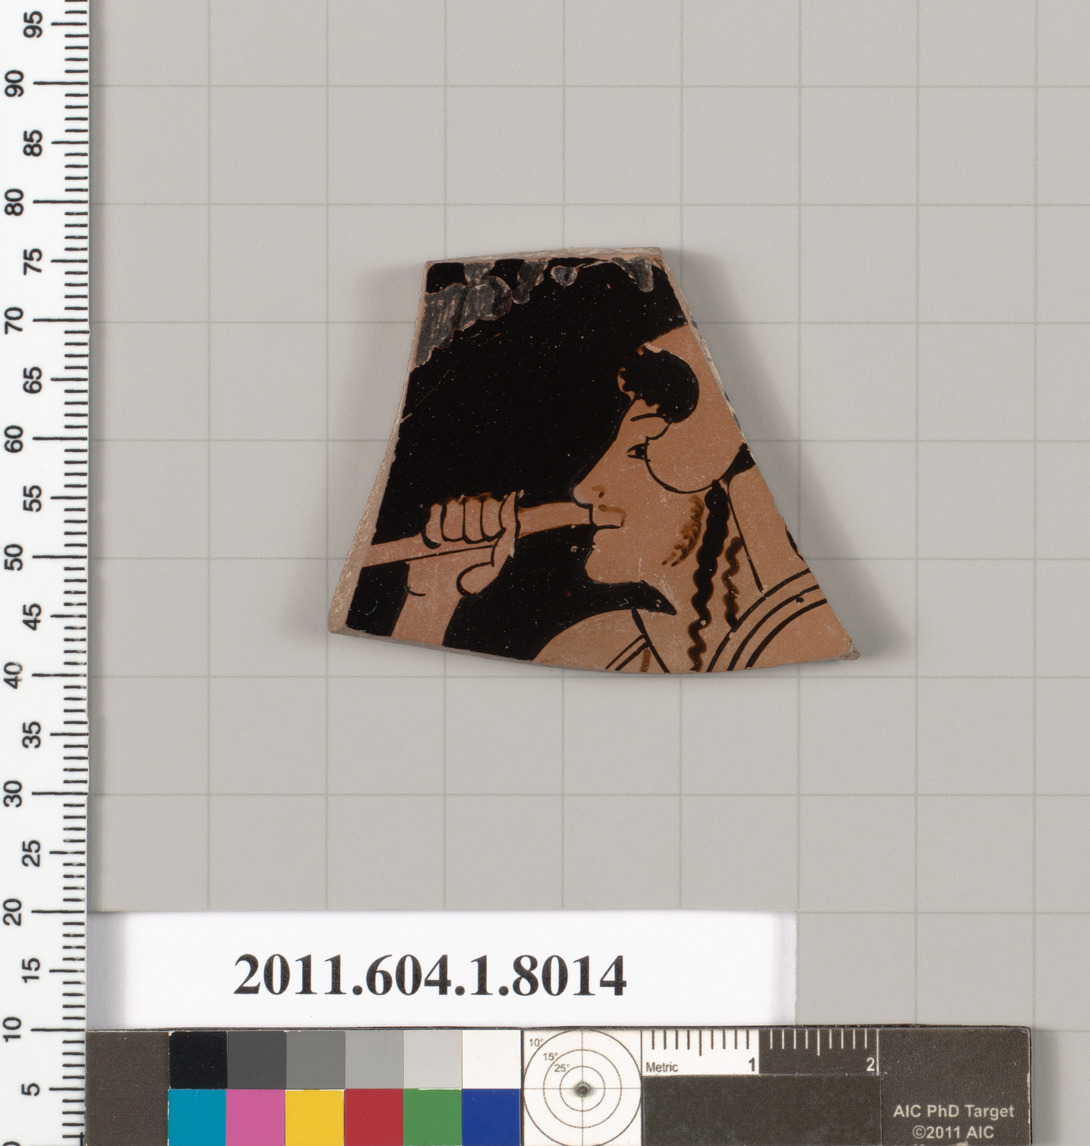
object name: kylix fragment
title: Terracotta fragment of a kylix (drinking cup)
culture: greek, attic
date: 510-500 BCE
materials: terracotta